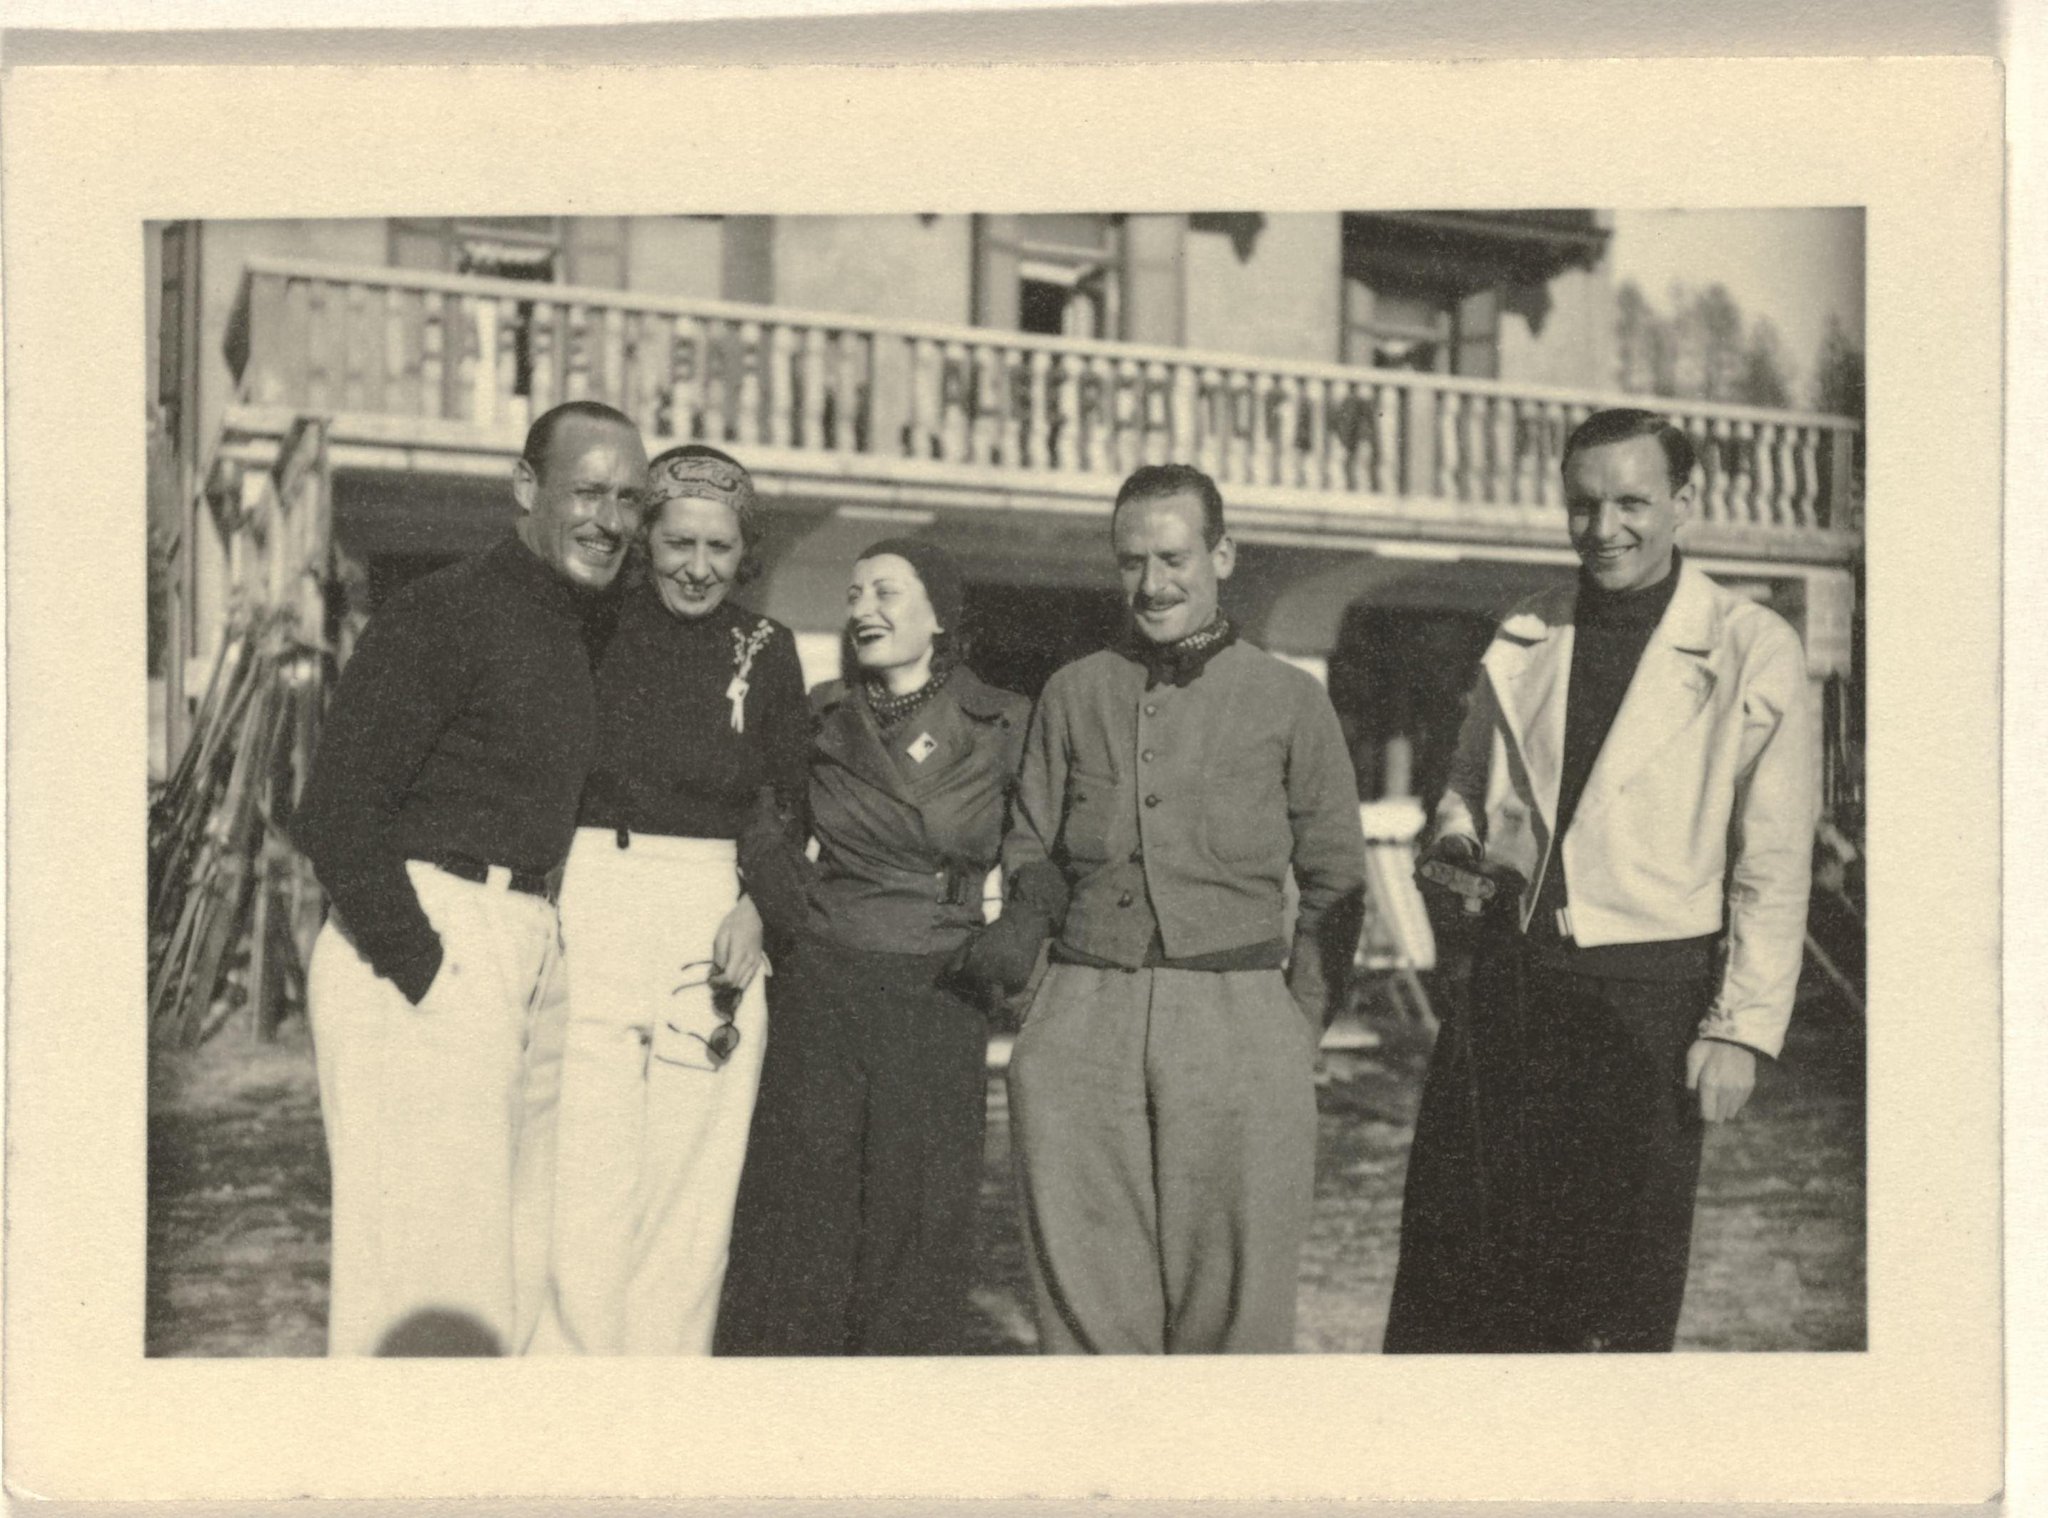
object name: photograph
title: Vijf onbekende mensen, met op de achtergrond een gebouw met daarop een balustrade en aan de linkerkant een verzameling skies leunend tegen het gebouw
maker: Anonymous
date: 1910-1940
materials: photographic support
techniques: gelatin silver print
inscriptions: inscription: ‘... ...’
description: Vijf onbekende mensen, met op de achtergrond een gebouw met daarop een balustrade en aan de linkerkant een verzameling skies leunend tegen het gebouw.